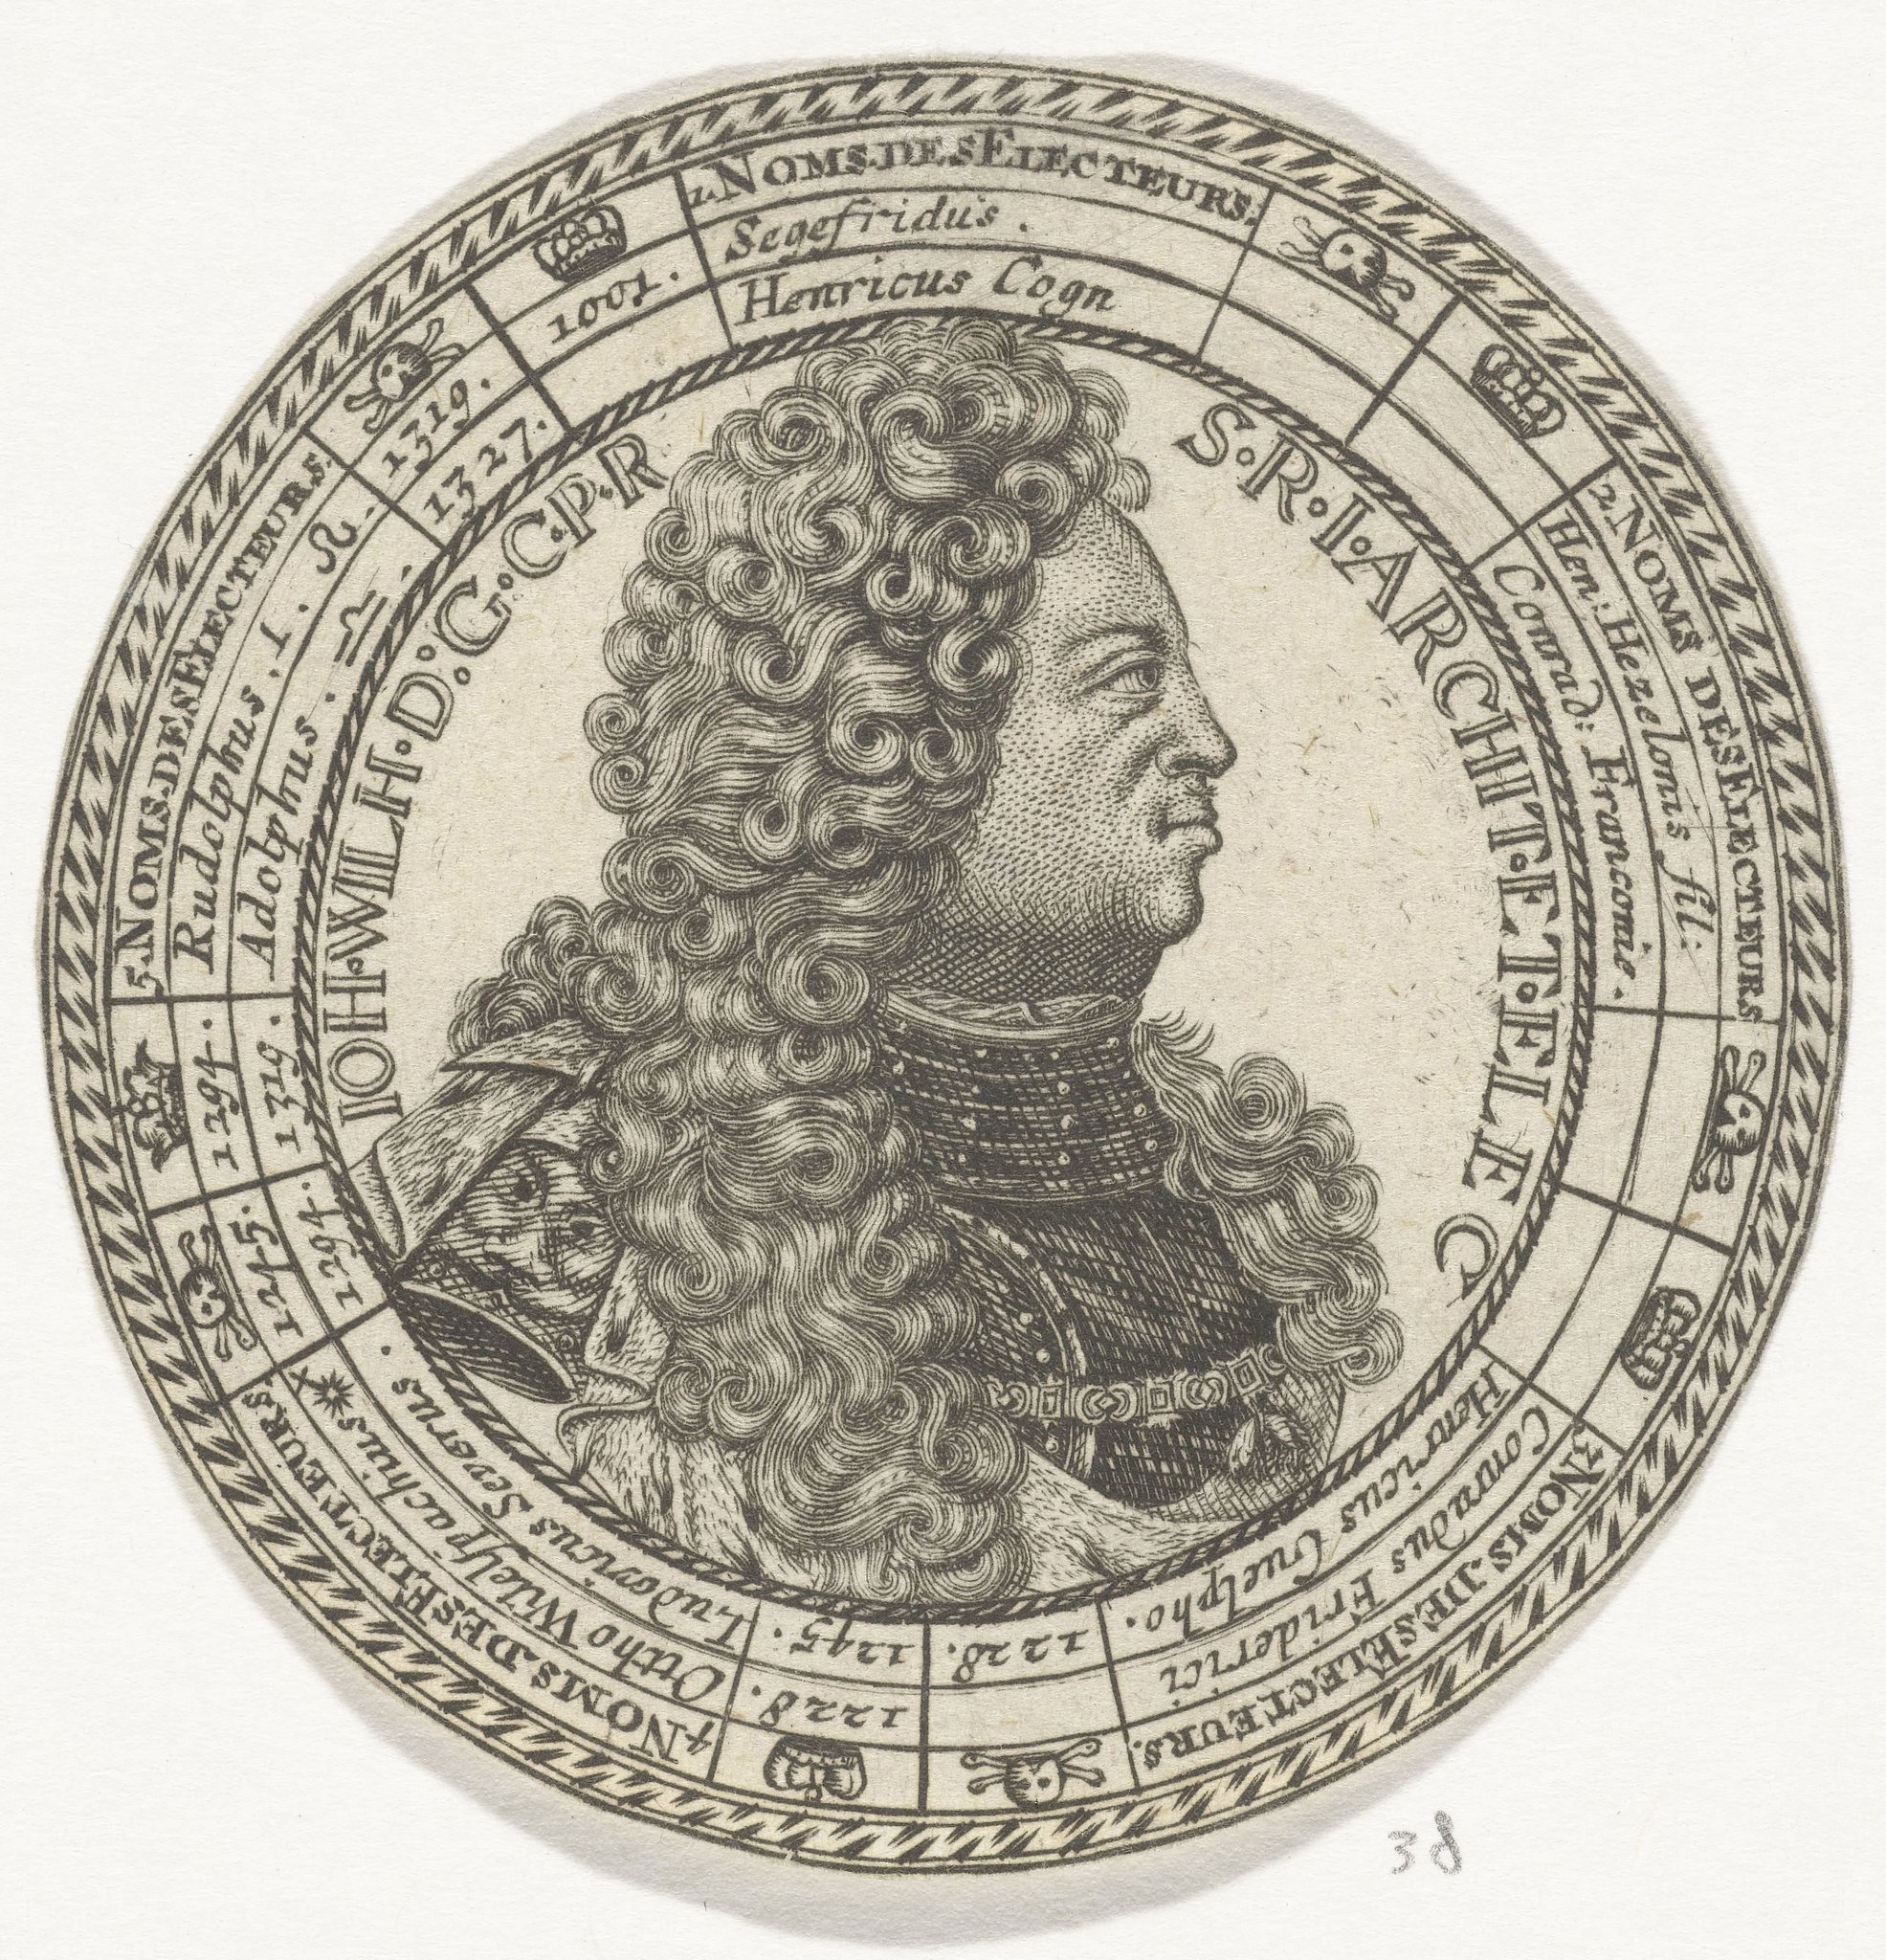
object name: print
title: Penning met het portret van Johan Willem en de namen van de keurvorsten van de Palts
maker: Anonymous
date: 1685-1716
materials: paper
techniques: etching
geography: amsterdam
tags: feudal lord, seal (symbol of sovereignty)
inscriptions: number: ‘39’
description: Ontwerp van een ronde penning met, in drie concentrische cirkels, de namen van de paltsgraven en hun regeringsjaren, beginnende bij Siegfried I en eindigend bij Adolf van de Palts. In het midden van de penning het portret van paltsgraaf Johan Willem.